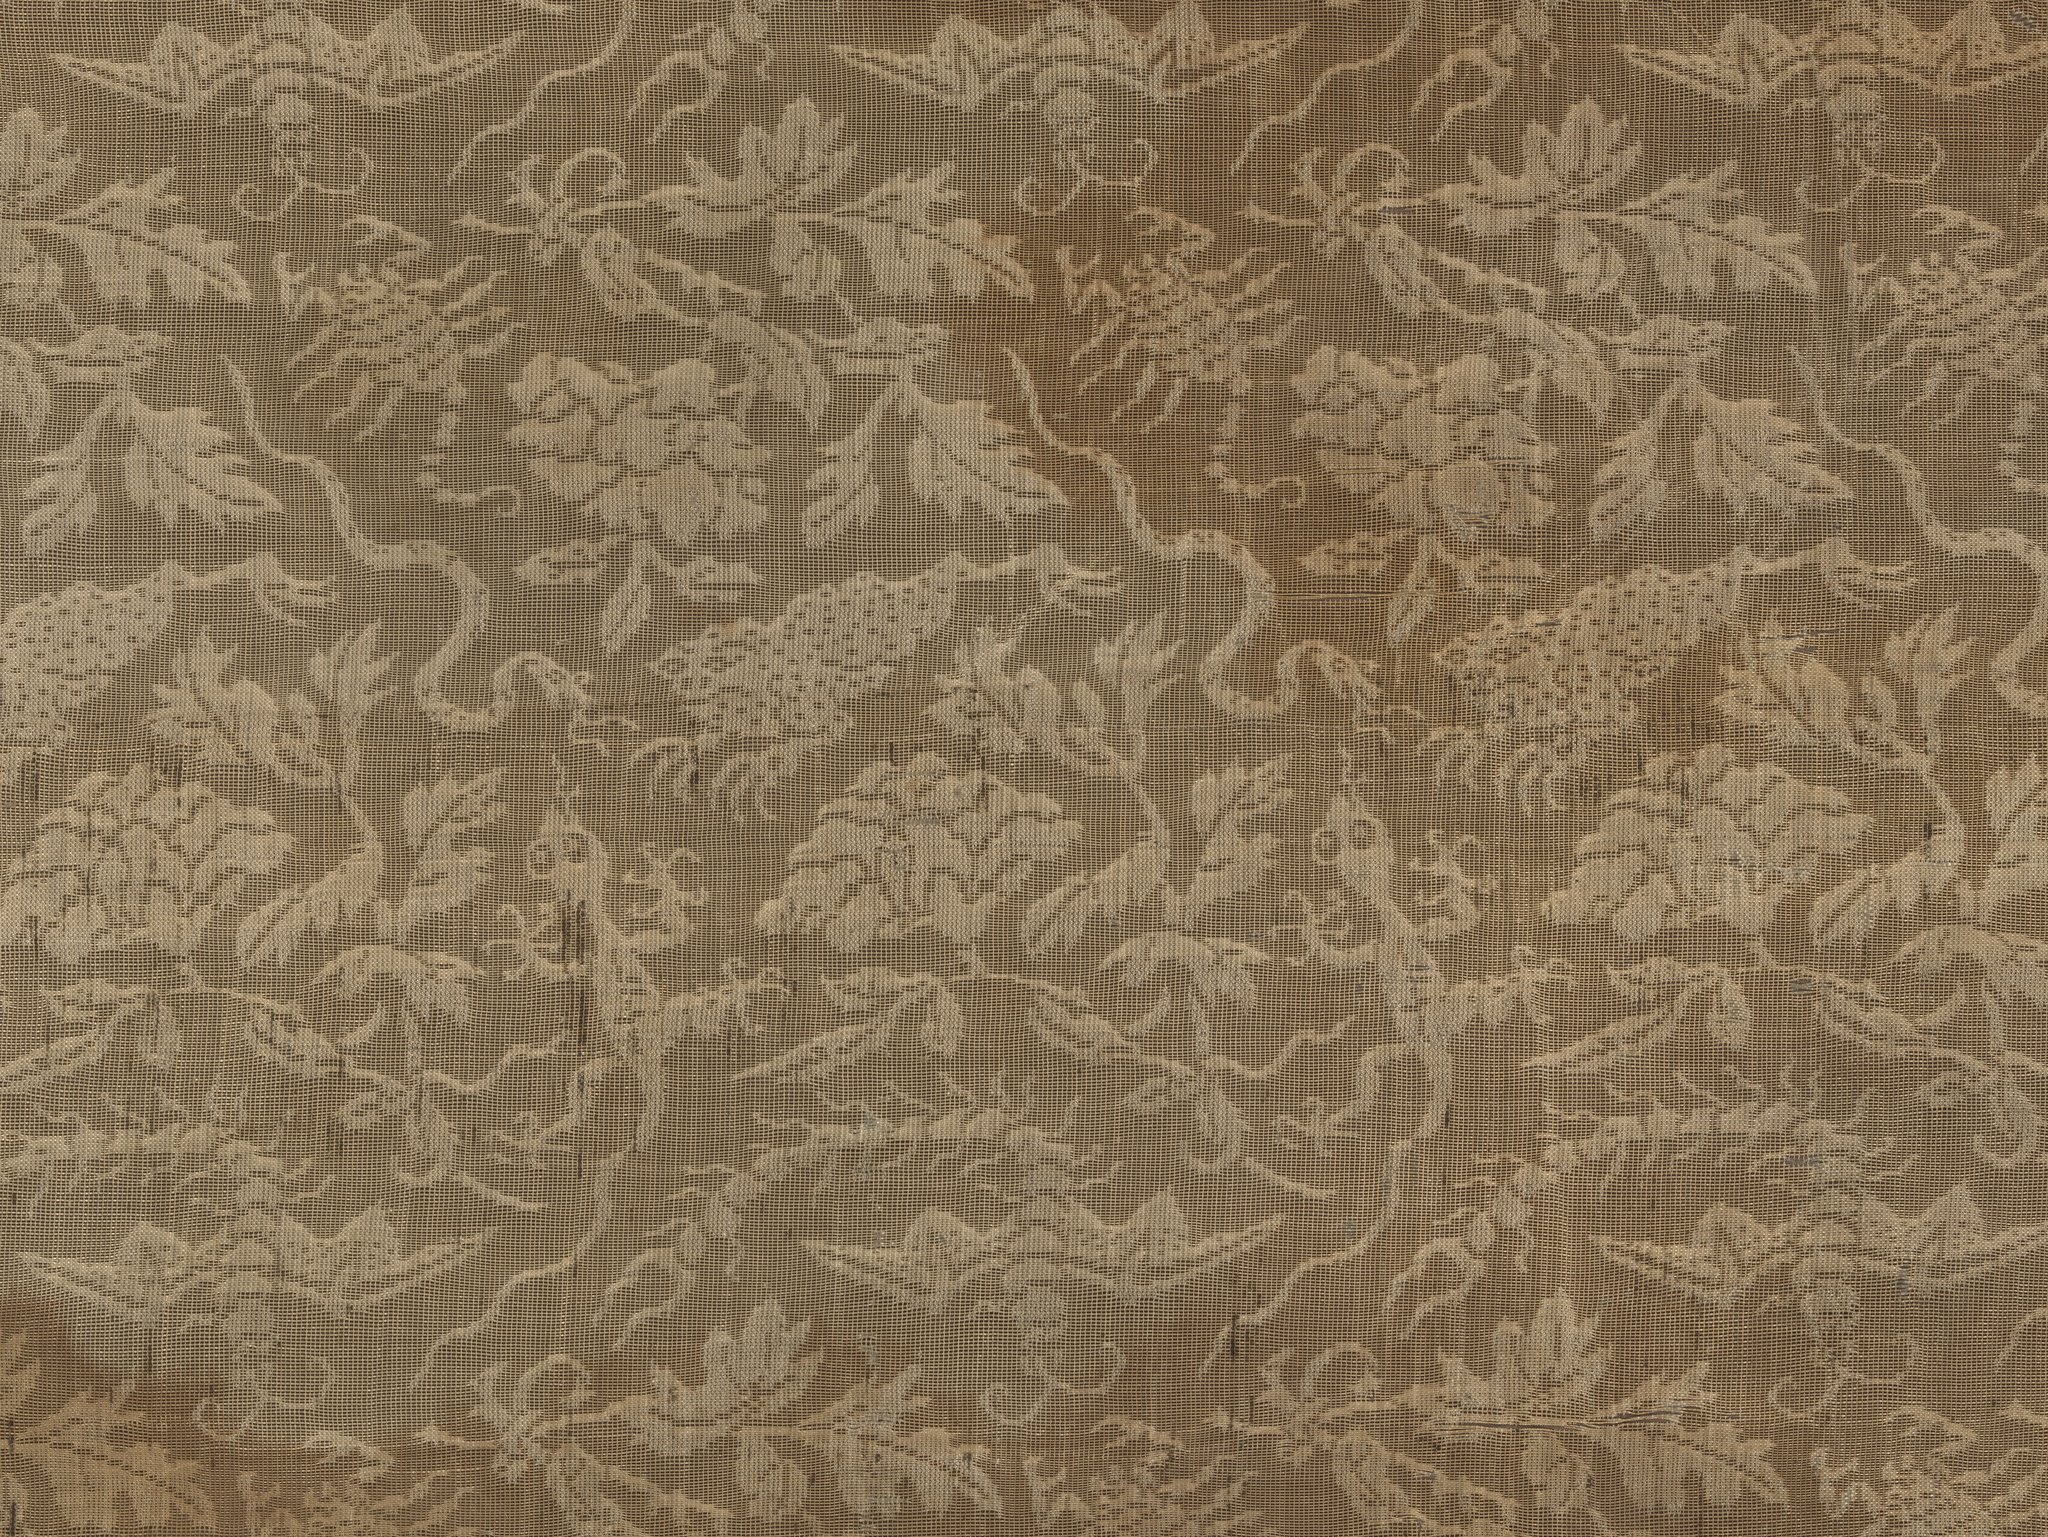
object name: panel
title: Panel with the five poisonous creatures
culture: chinese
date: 1572-1620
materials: textile, silk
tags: scorpions,snakes